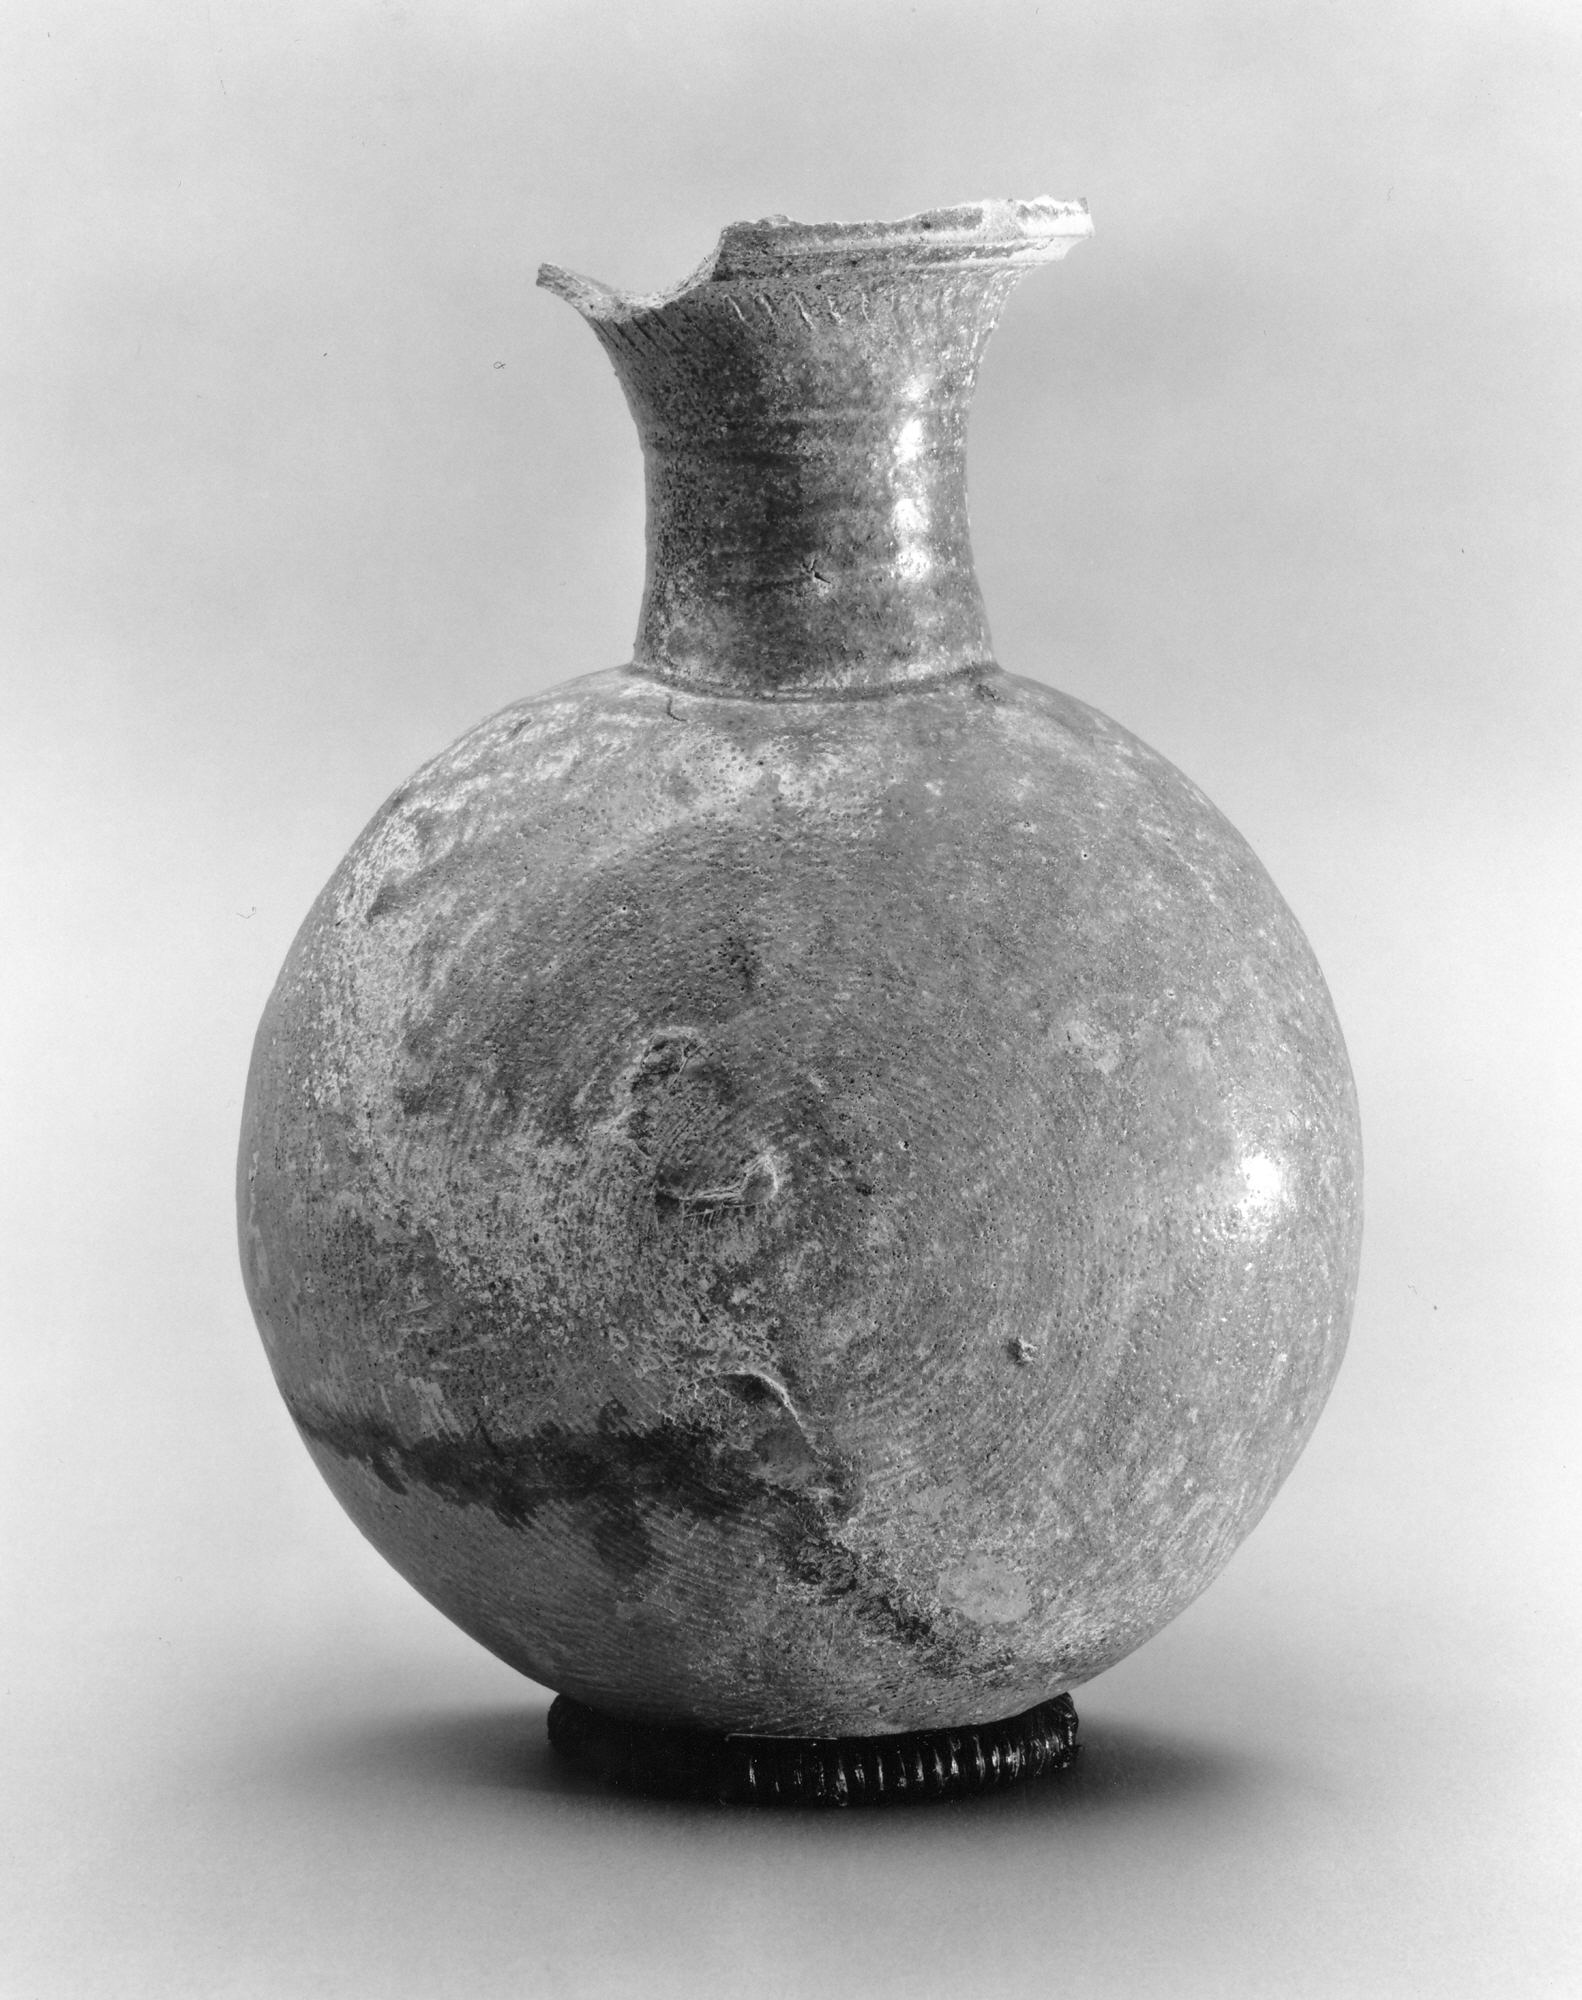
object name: flask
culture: japanese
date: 710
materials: wood, glaze, stoneware